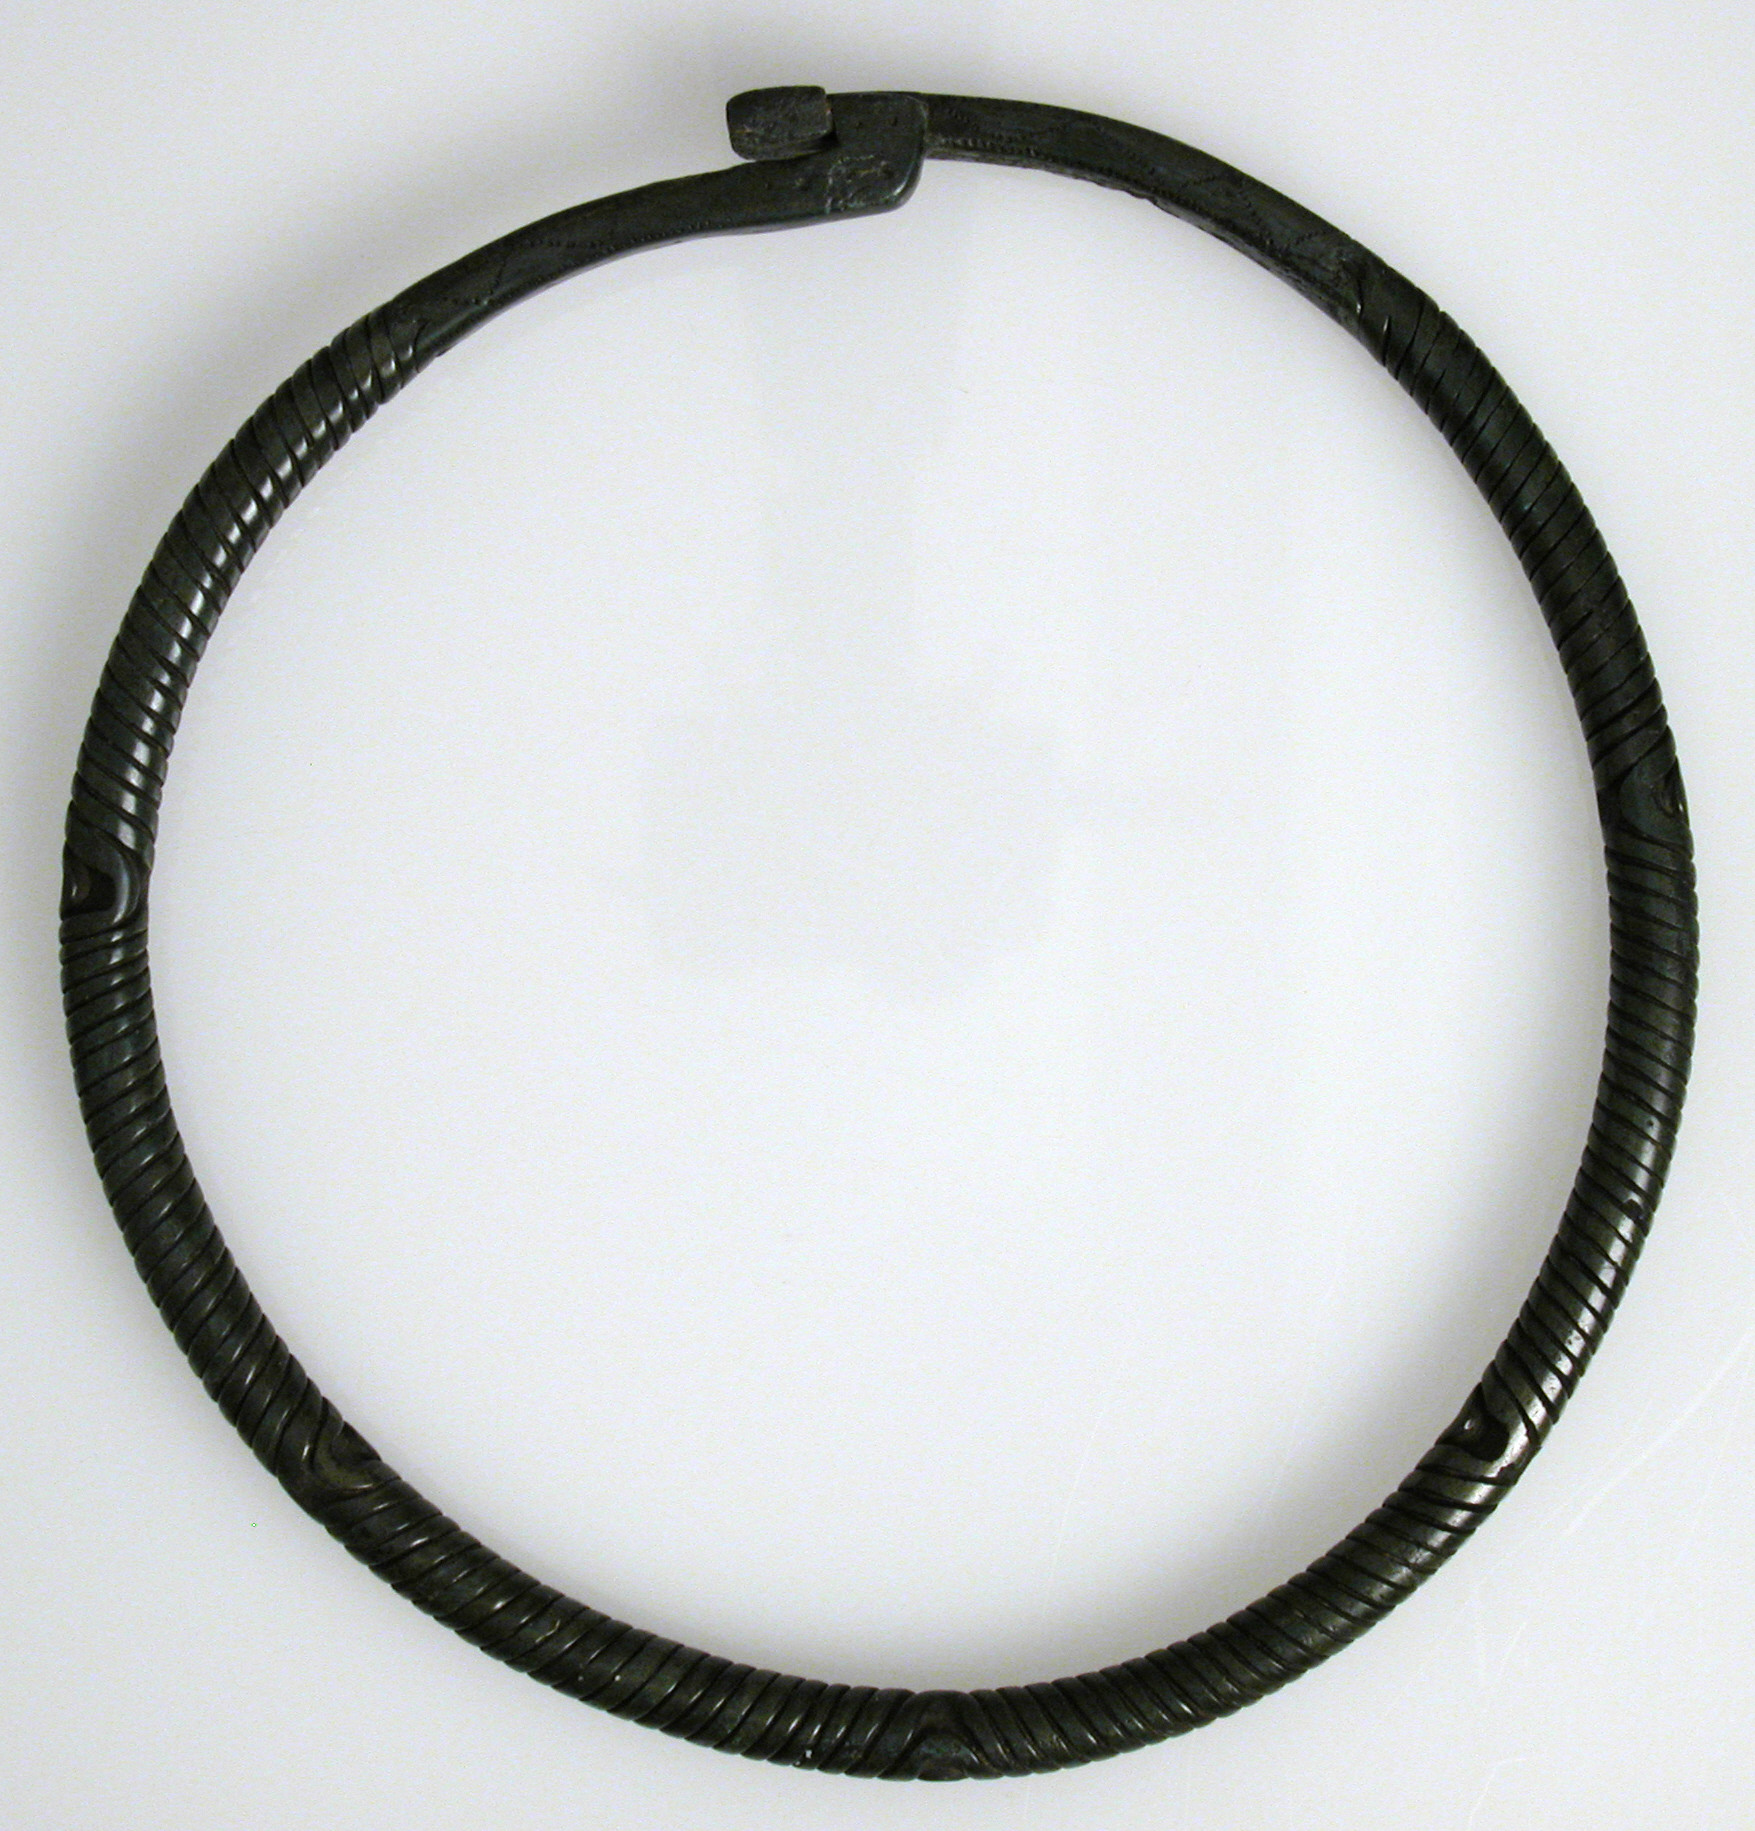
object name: torc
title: Neck Ring (Torque)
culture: scandinavian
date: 600 BCE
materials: copper alloy